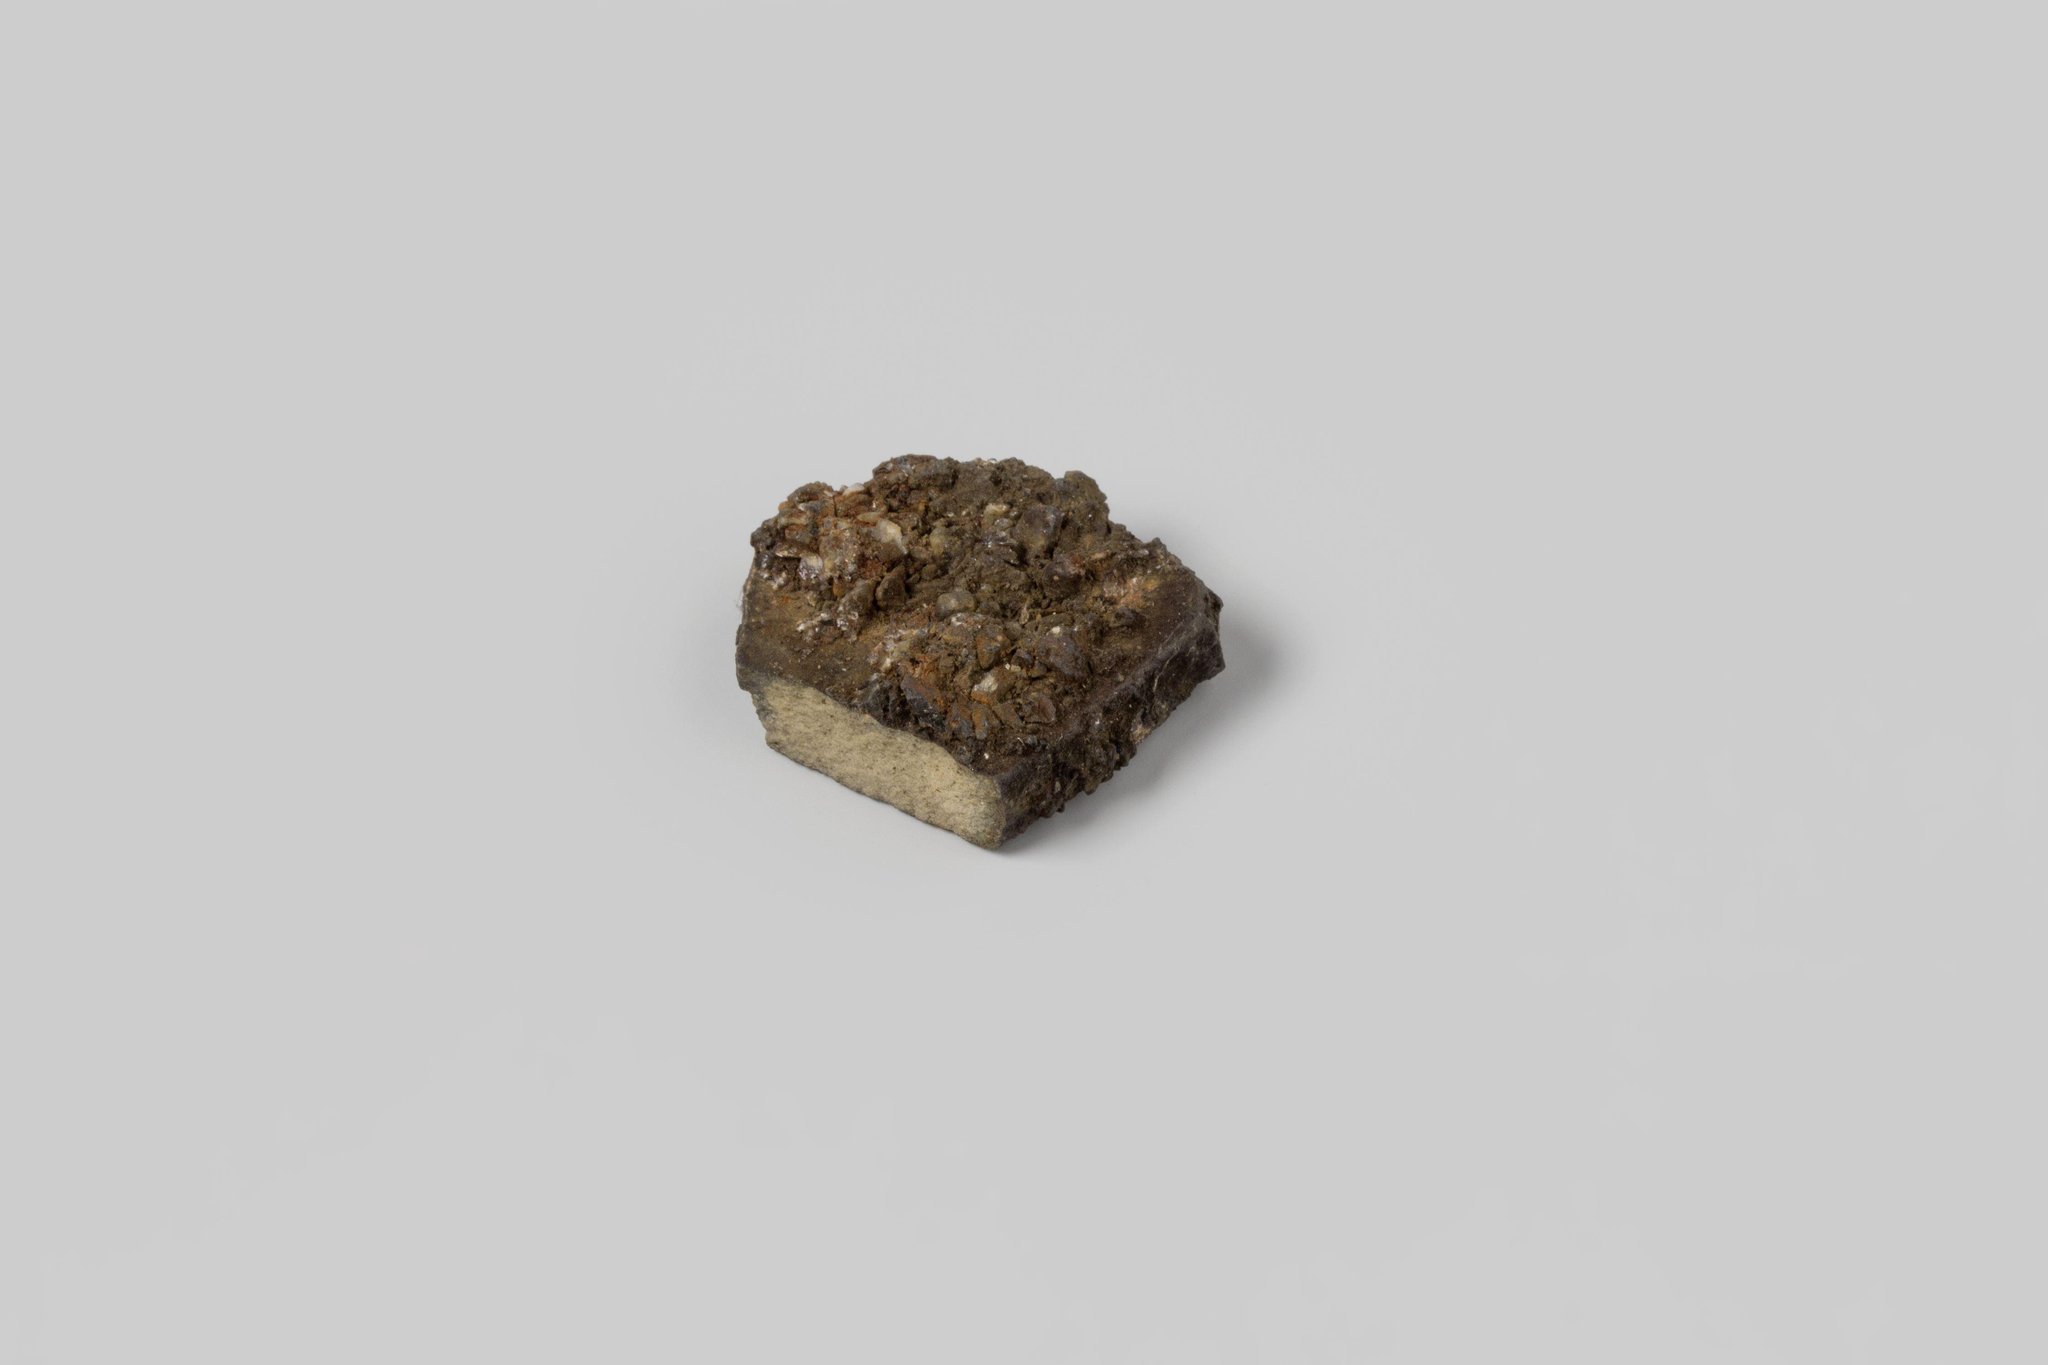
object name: sherd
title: Scherf van een voorraadpot uit het wrak van de Oost-Indiëvaarder Hollandia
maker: Anonymous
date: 1700-1743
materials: stoneware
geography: cologne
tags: verenigde oostindische compagnie, hollandia (schip), annet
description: Stoneware, Rhenish, Langerwehe-ware, storage-jar; fragm of body, sim. NG 1980-27H409.